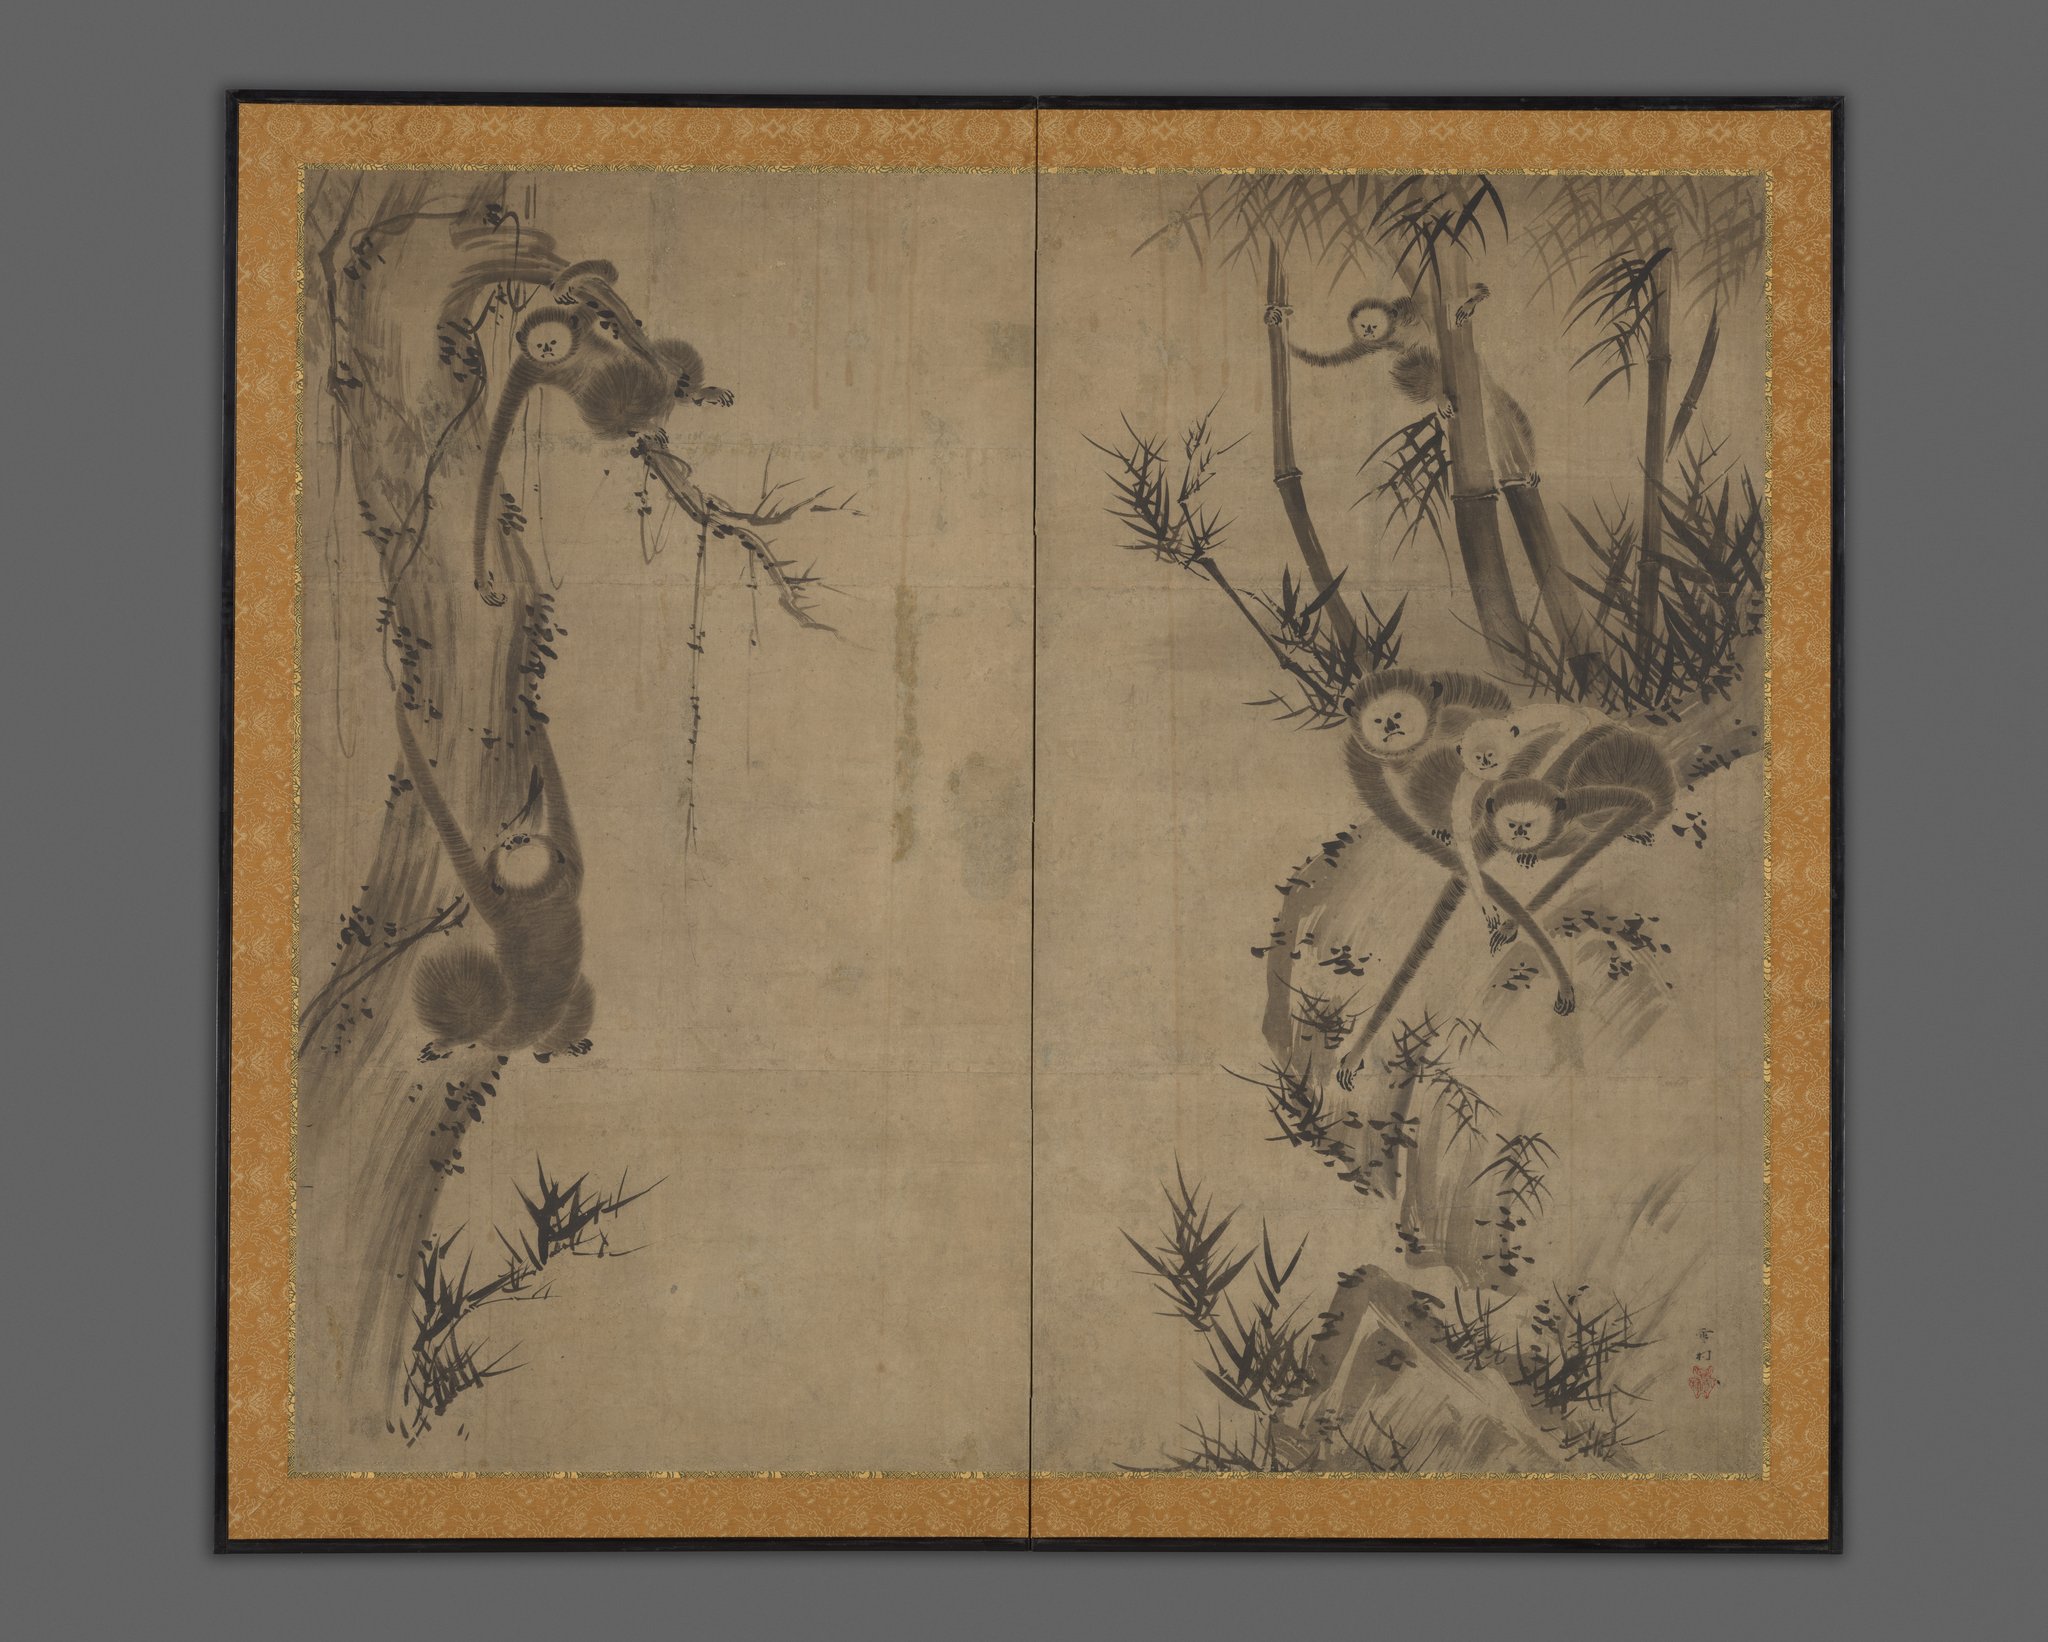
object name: screen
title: Monkeys on Rocks and Trees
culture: japanese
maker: sesson shūkei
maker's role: artist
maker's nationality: japanese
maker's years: 1504-1589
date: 1601-1700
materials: ink, panel, paper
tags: monkeys,trees